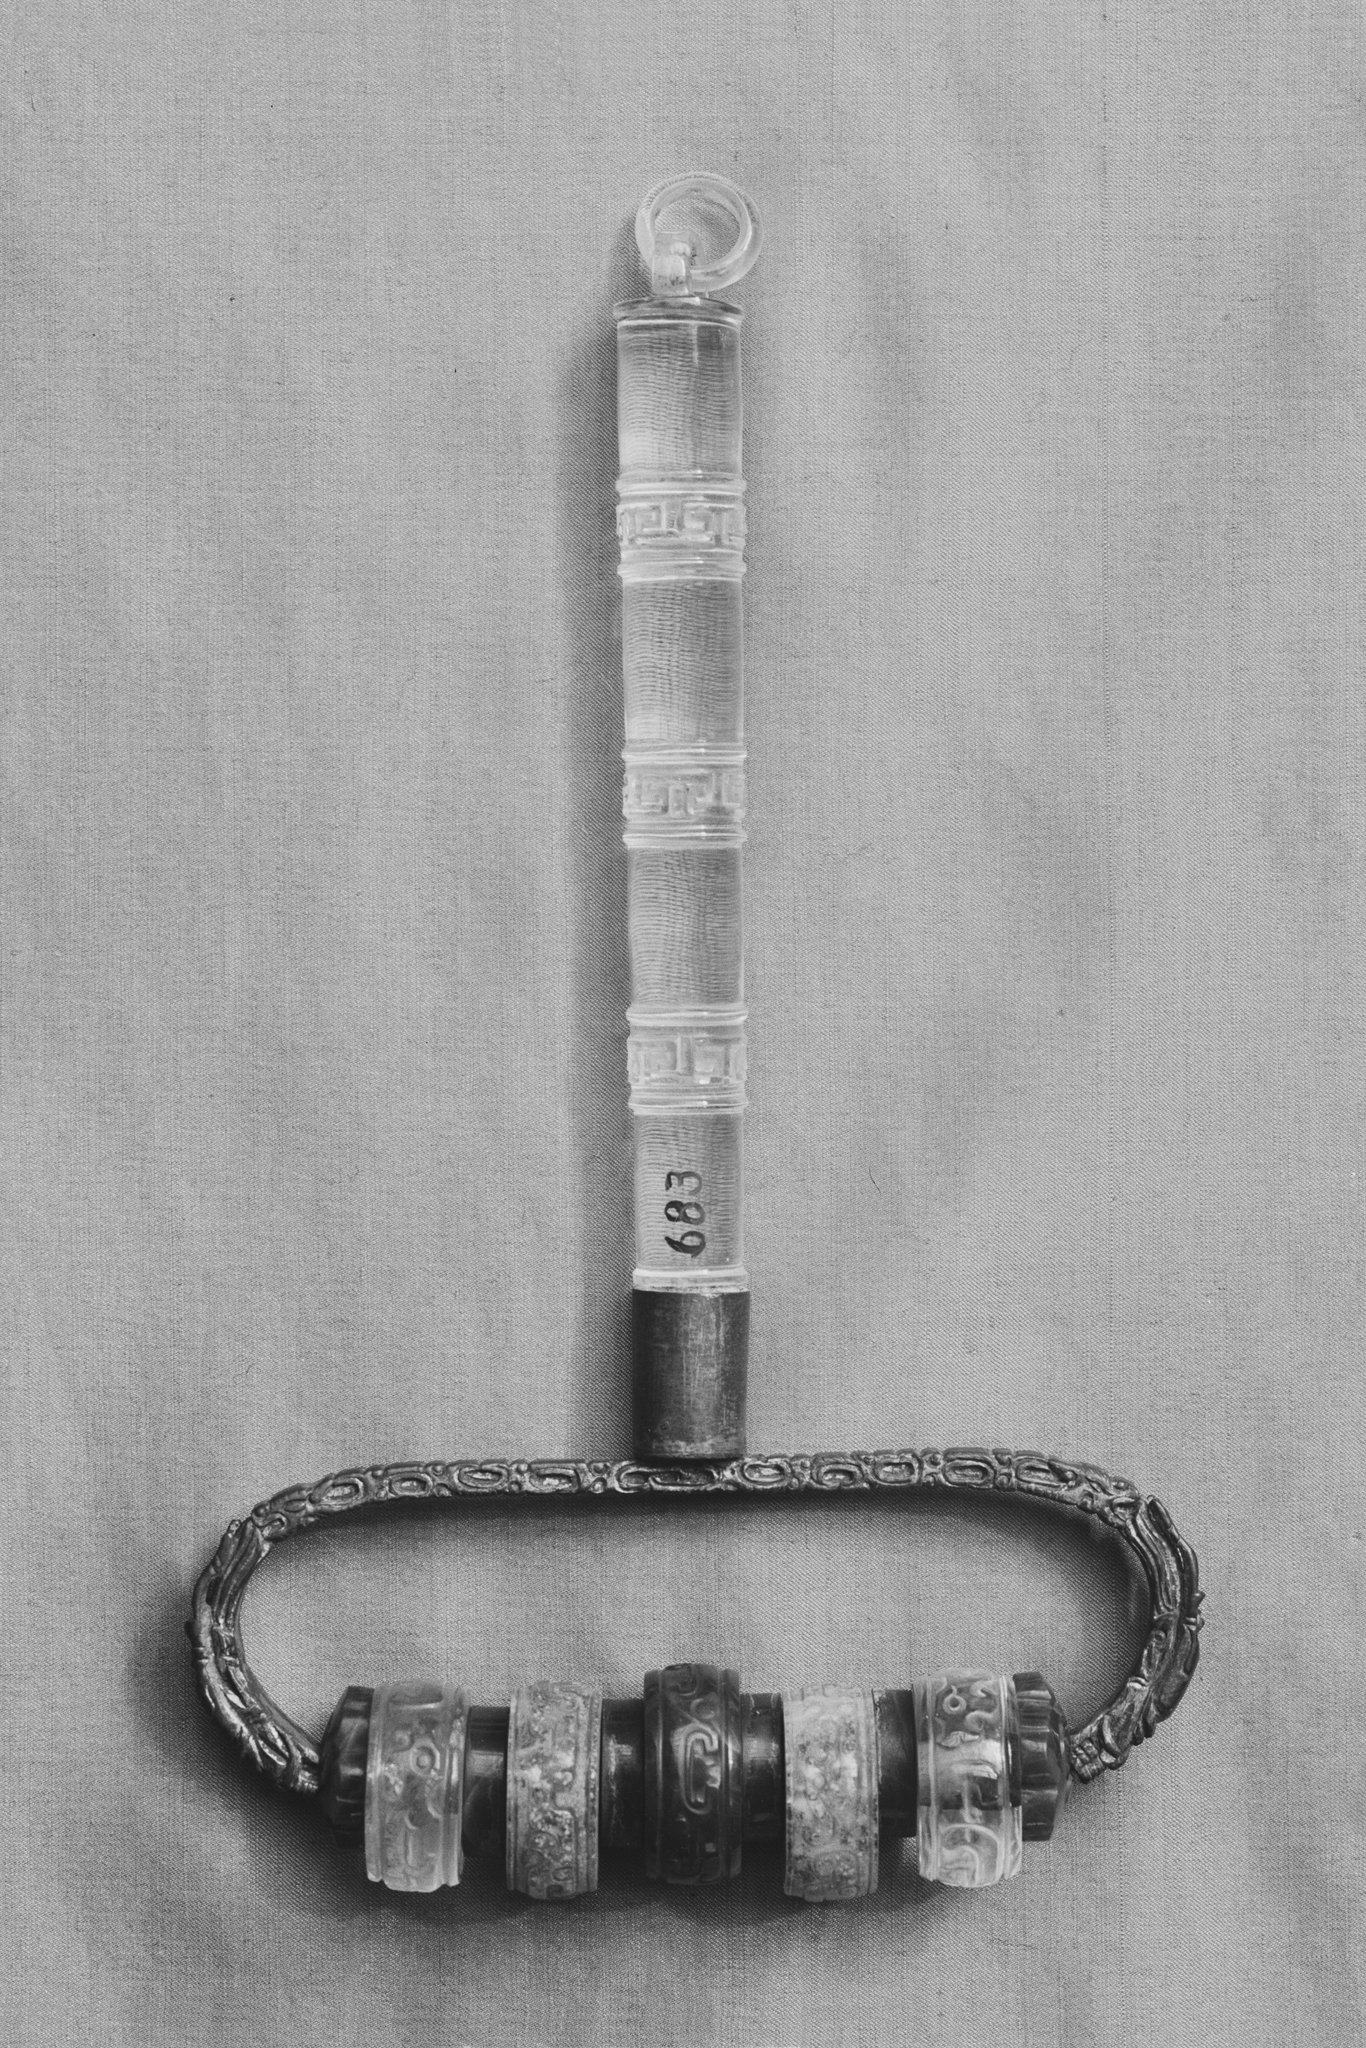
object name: massage implement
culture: chinese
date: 1701-1800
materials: gemstone, crystal, gilt, gilt bronze, quartz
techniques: engraving